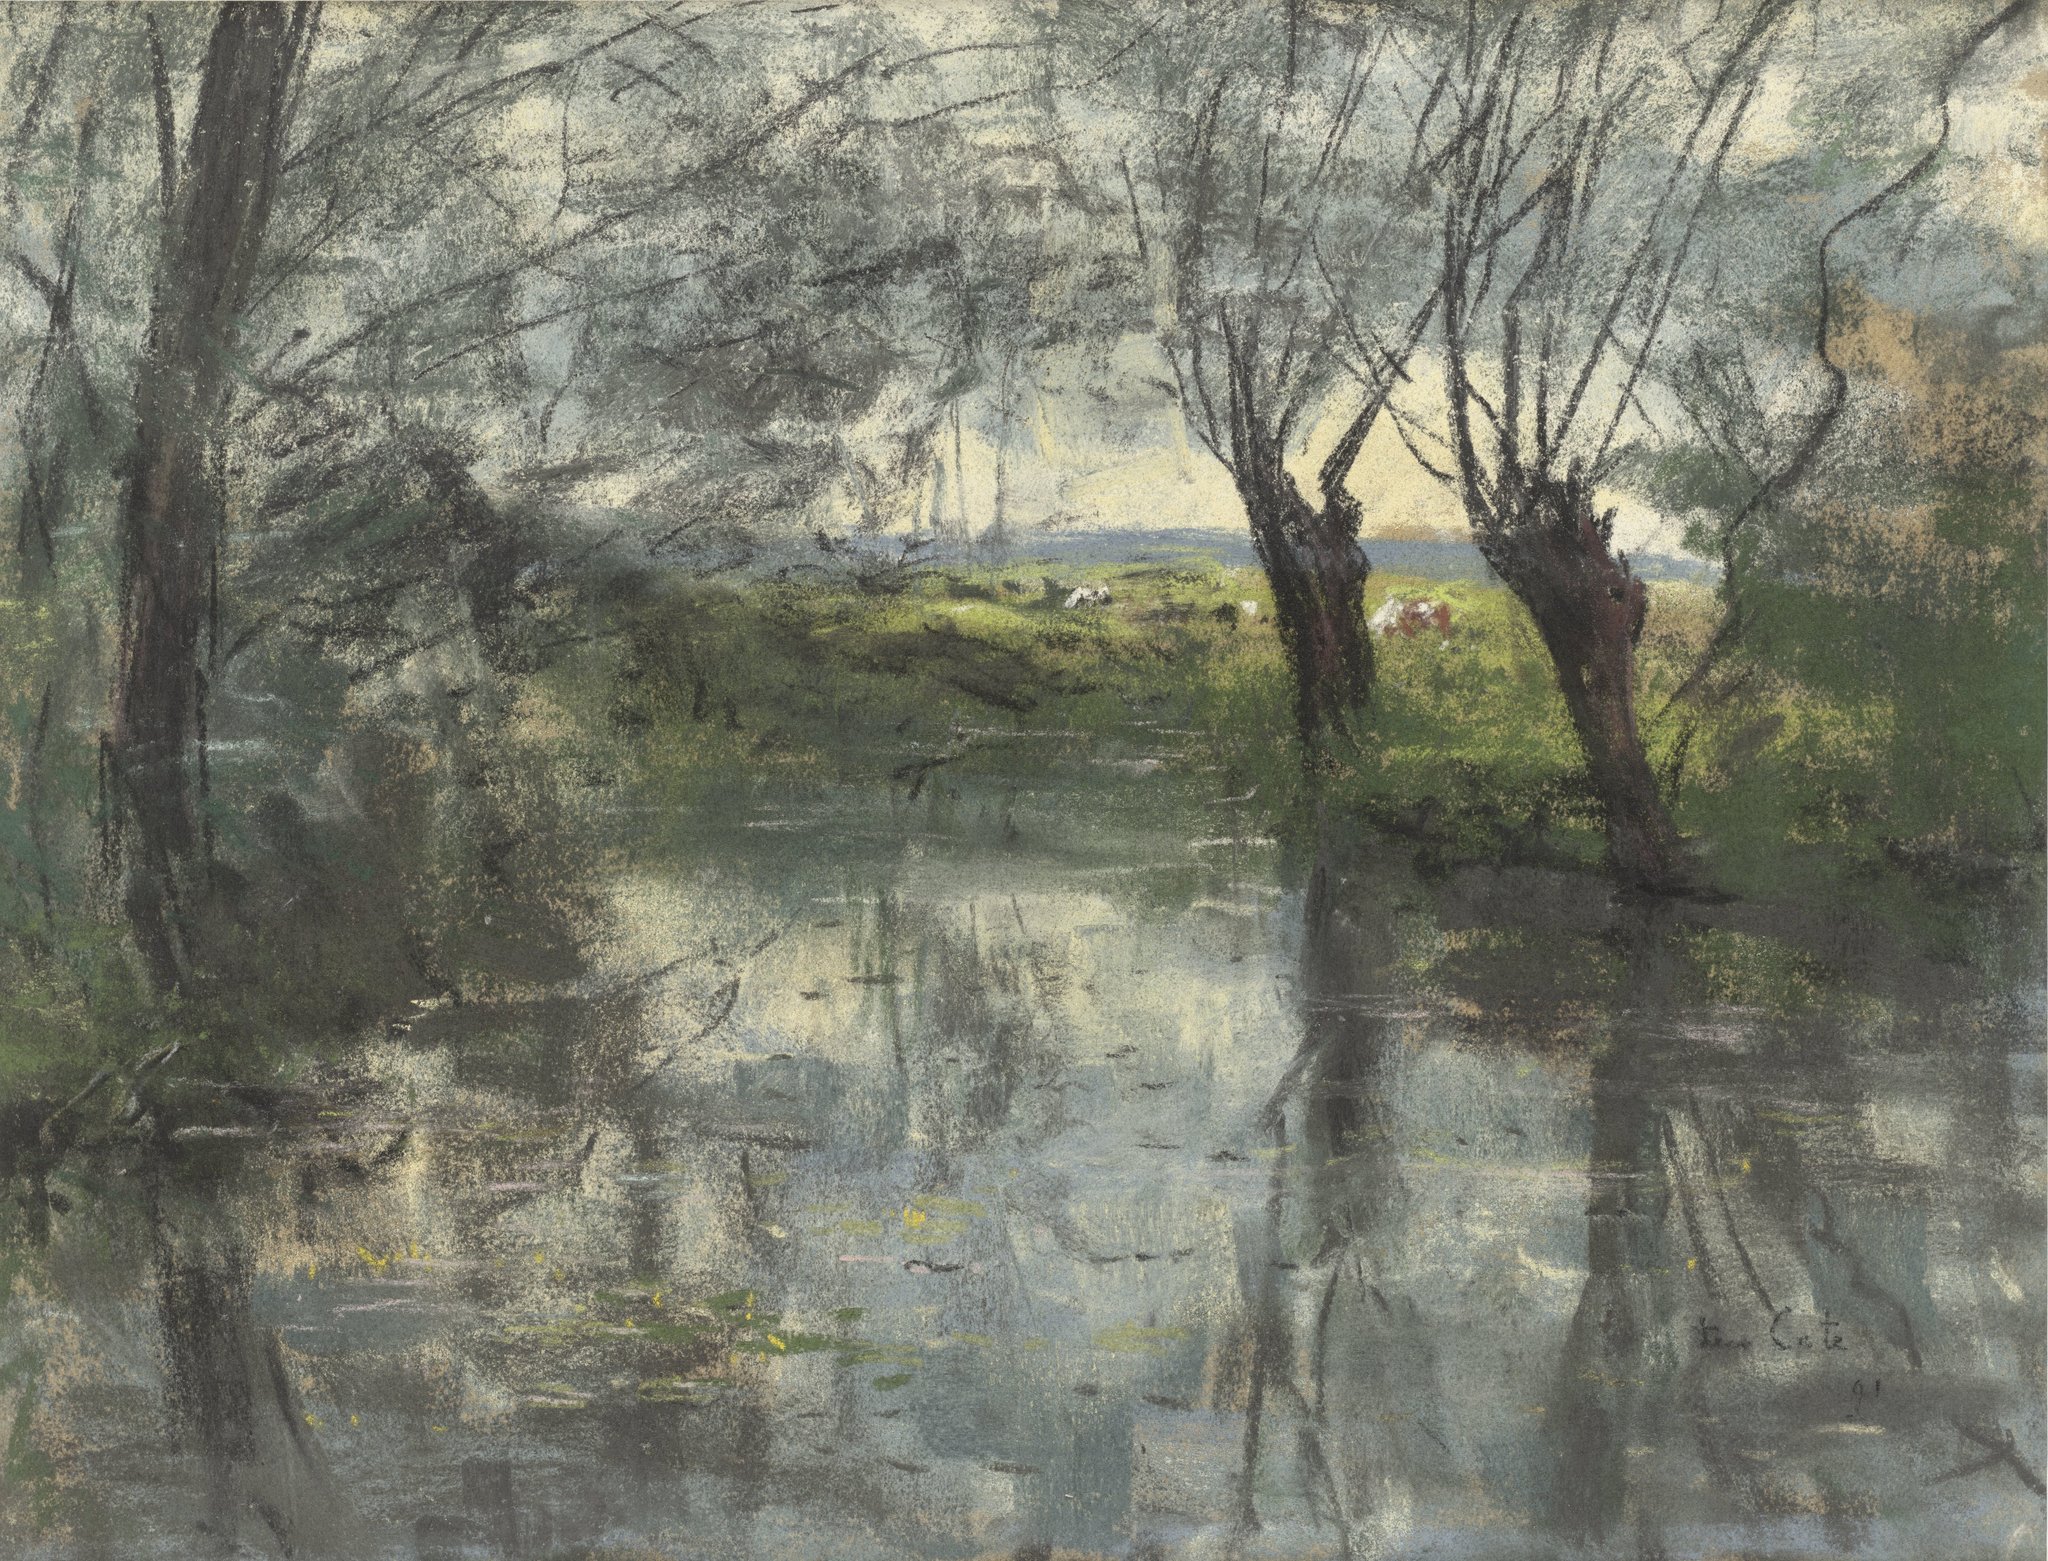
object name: drawing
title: Bosvijver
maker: siebe johannes ten cate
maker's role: draughtsman, print maker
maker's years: 1858-1908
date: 1891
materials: paper, pastel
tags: forest, wood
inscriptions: signature and date: ‘ten Cate / 91’